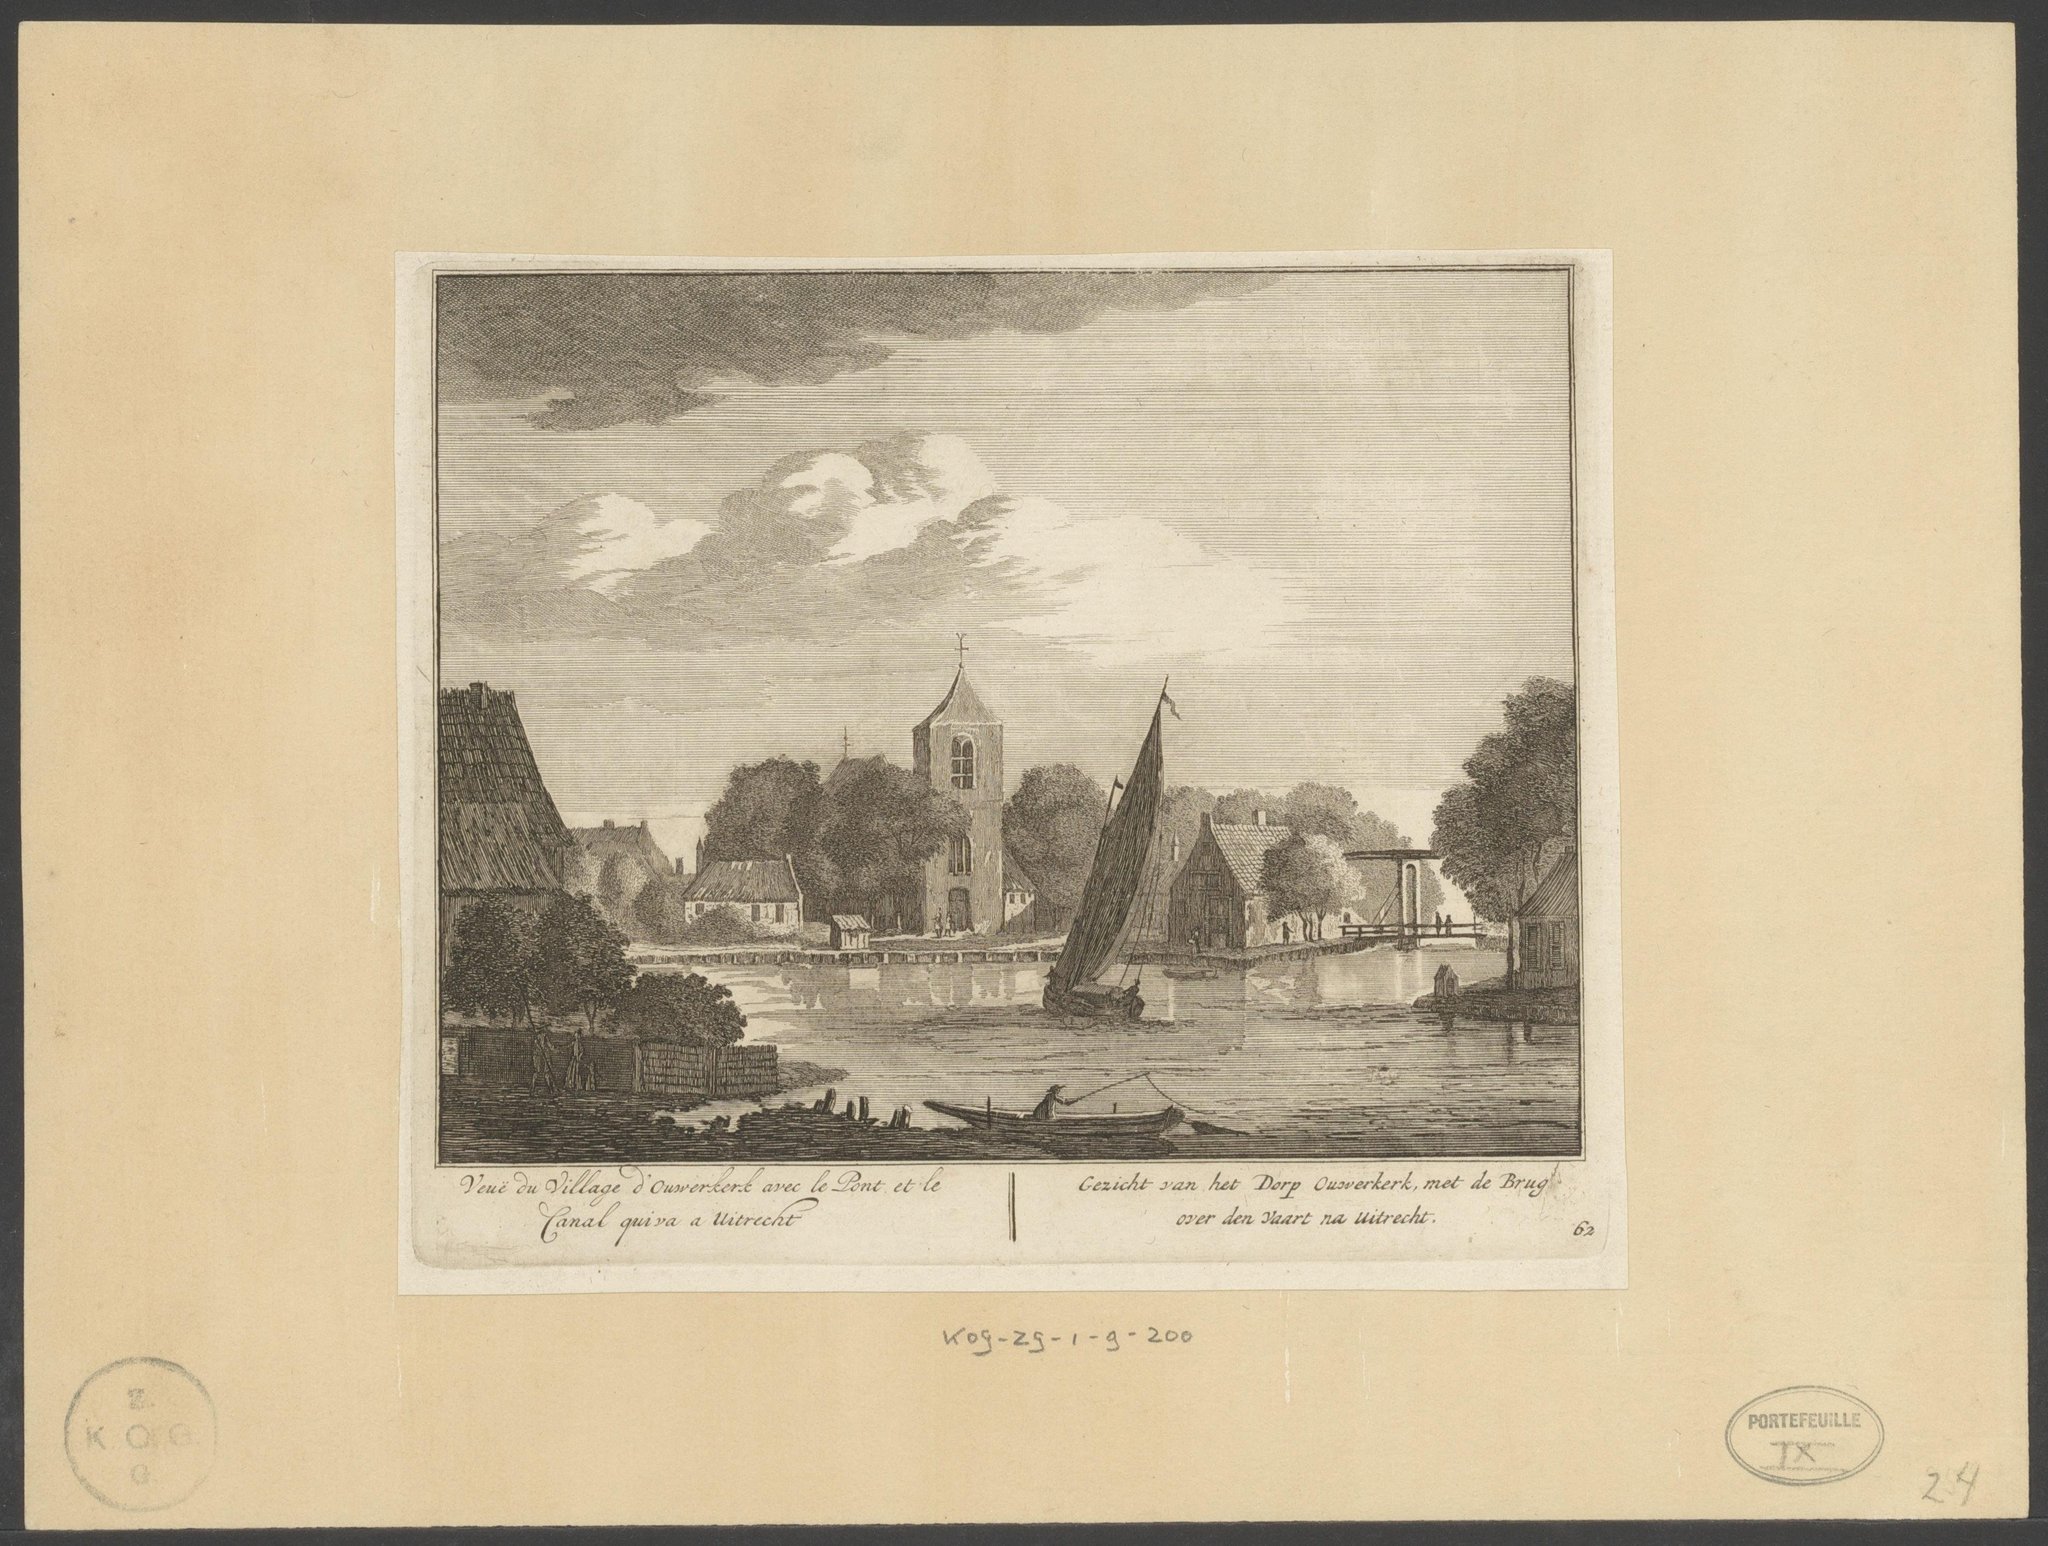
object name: print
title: Gezicht op de Amstel bij Ouderkerk aan de Amstel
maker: matthijs pool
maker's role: print maker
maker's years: 1676-1740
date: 1708-1740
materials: paper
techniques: engraving, etching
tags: sailing-ship, sailing-boat, church (exterior), bridge in village across river, canal, etc.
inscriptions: collector's mark: Lugt 1641, stamp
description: Eerdere staat gebruikt in: Pool, Matthijs. Verscheyde gesigten van de vermaarde rievier de buyten Amstel van de stadt Amsterdam, tot het dorp Ouwerkerk (…) / Plusieurs veuës et perspectives de la fameuse riviére de Buyten-Amstel depuis Amsterdam jusqu'au village d'Ouwerkerk (…). Amsterdam: Matthijs Pool, z.j. [1708-1740].